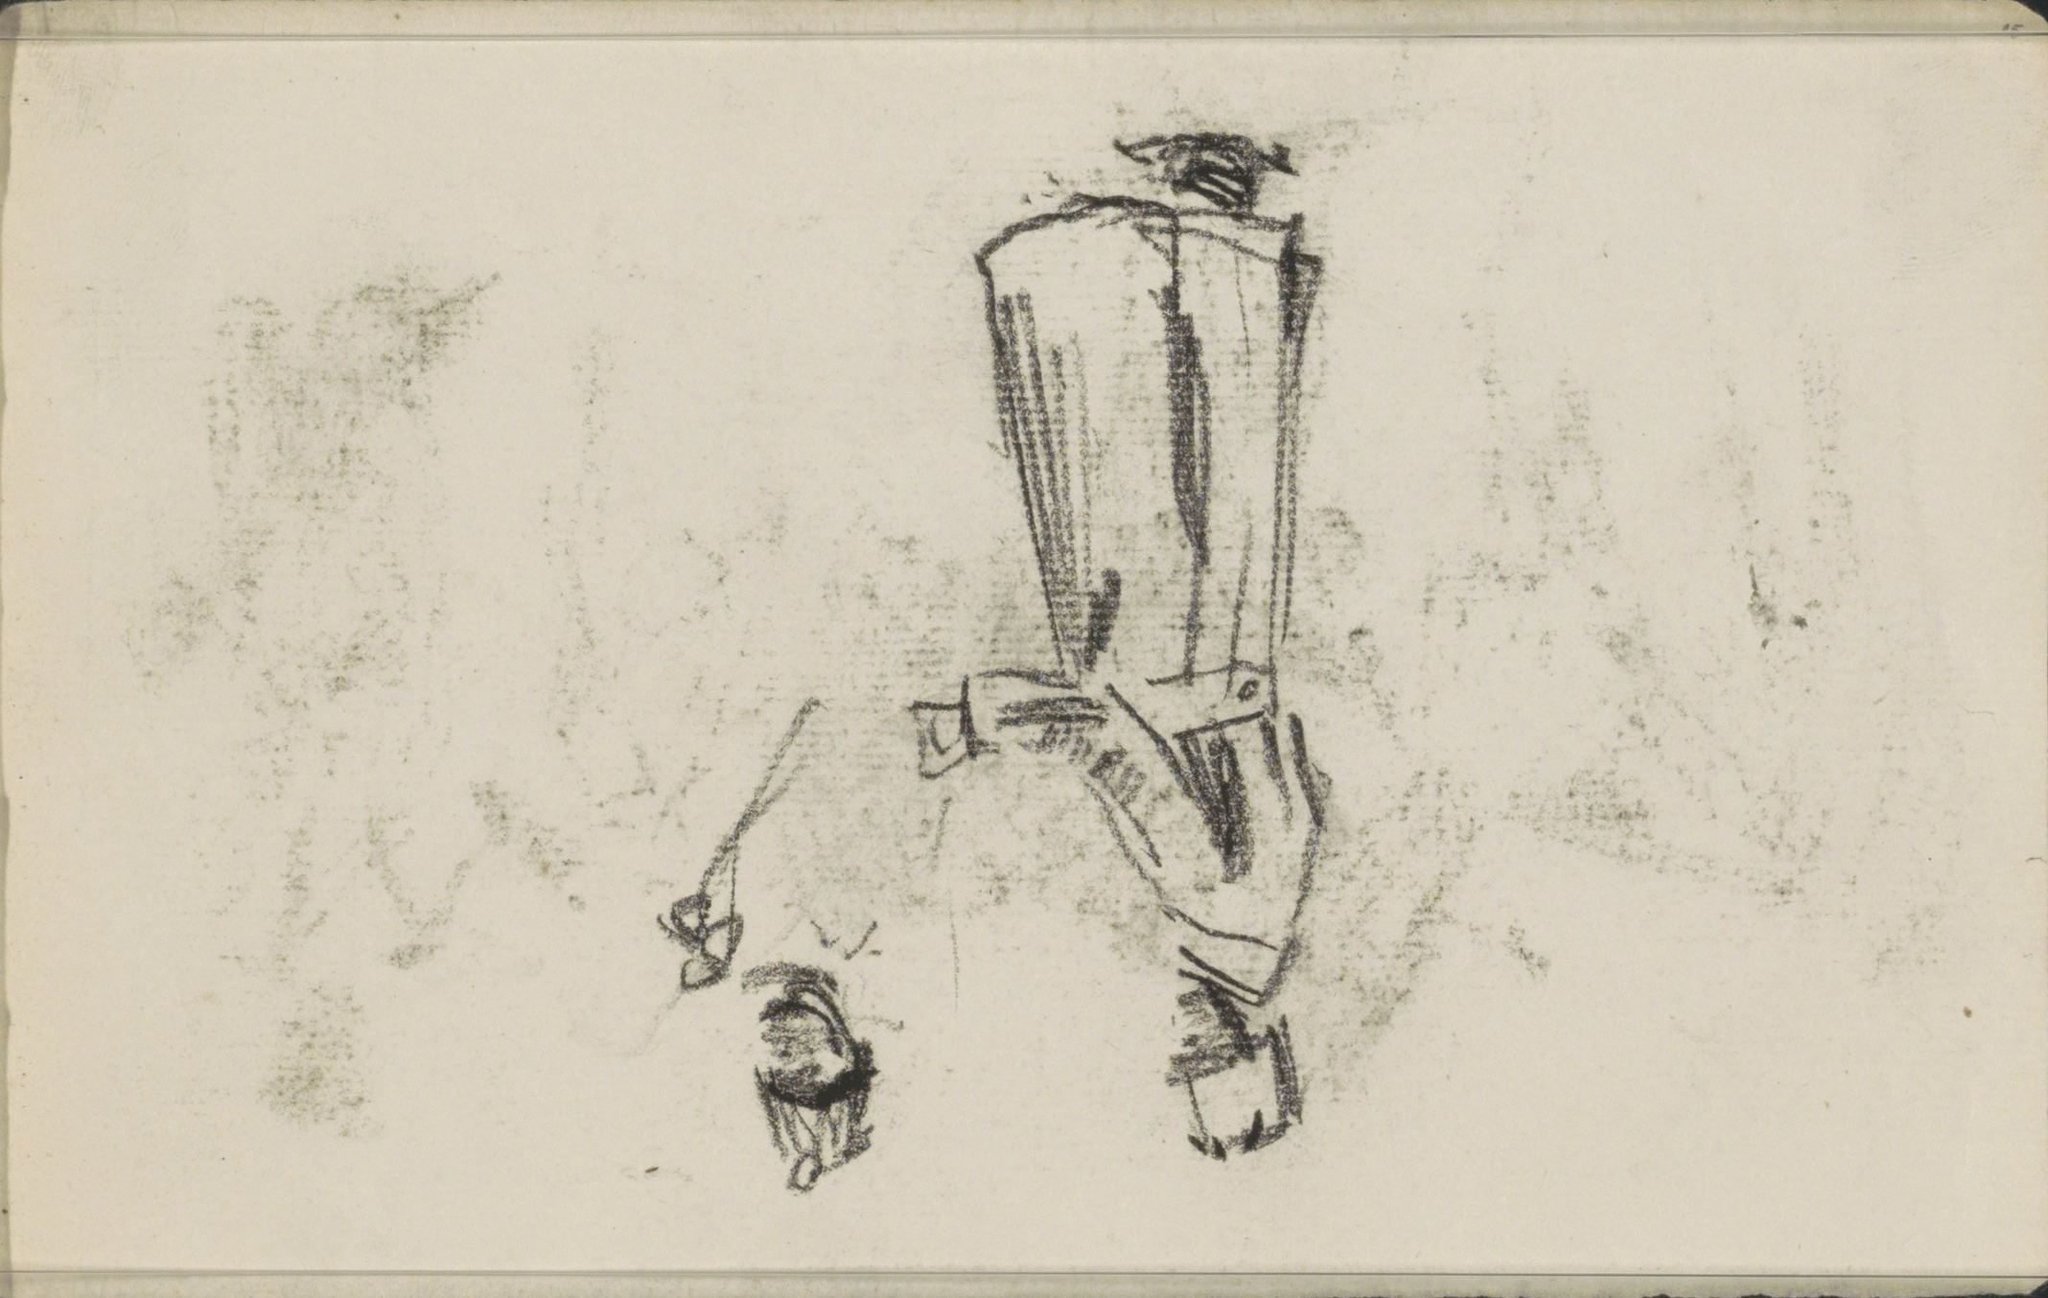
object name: sketchbook leaf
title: Soldaat in lange overjas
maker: marius bauer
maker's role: draughtsman, print maker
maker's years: 1867-1932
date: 1877-1885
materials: chalk, paper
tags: helmet, head (human), standing figure, coat (+ men's clothes), private soldier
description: De figuur draagt een helm. Tevens een studie van een mannenkop met helm. Pagina 15 uit een schetsboek met 8 bladen.